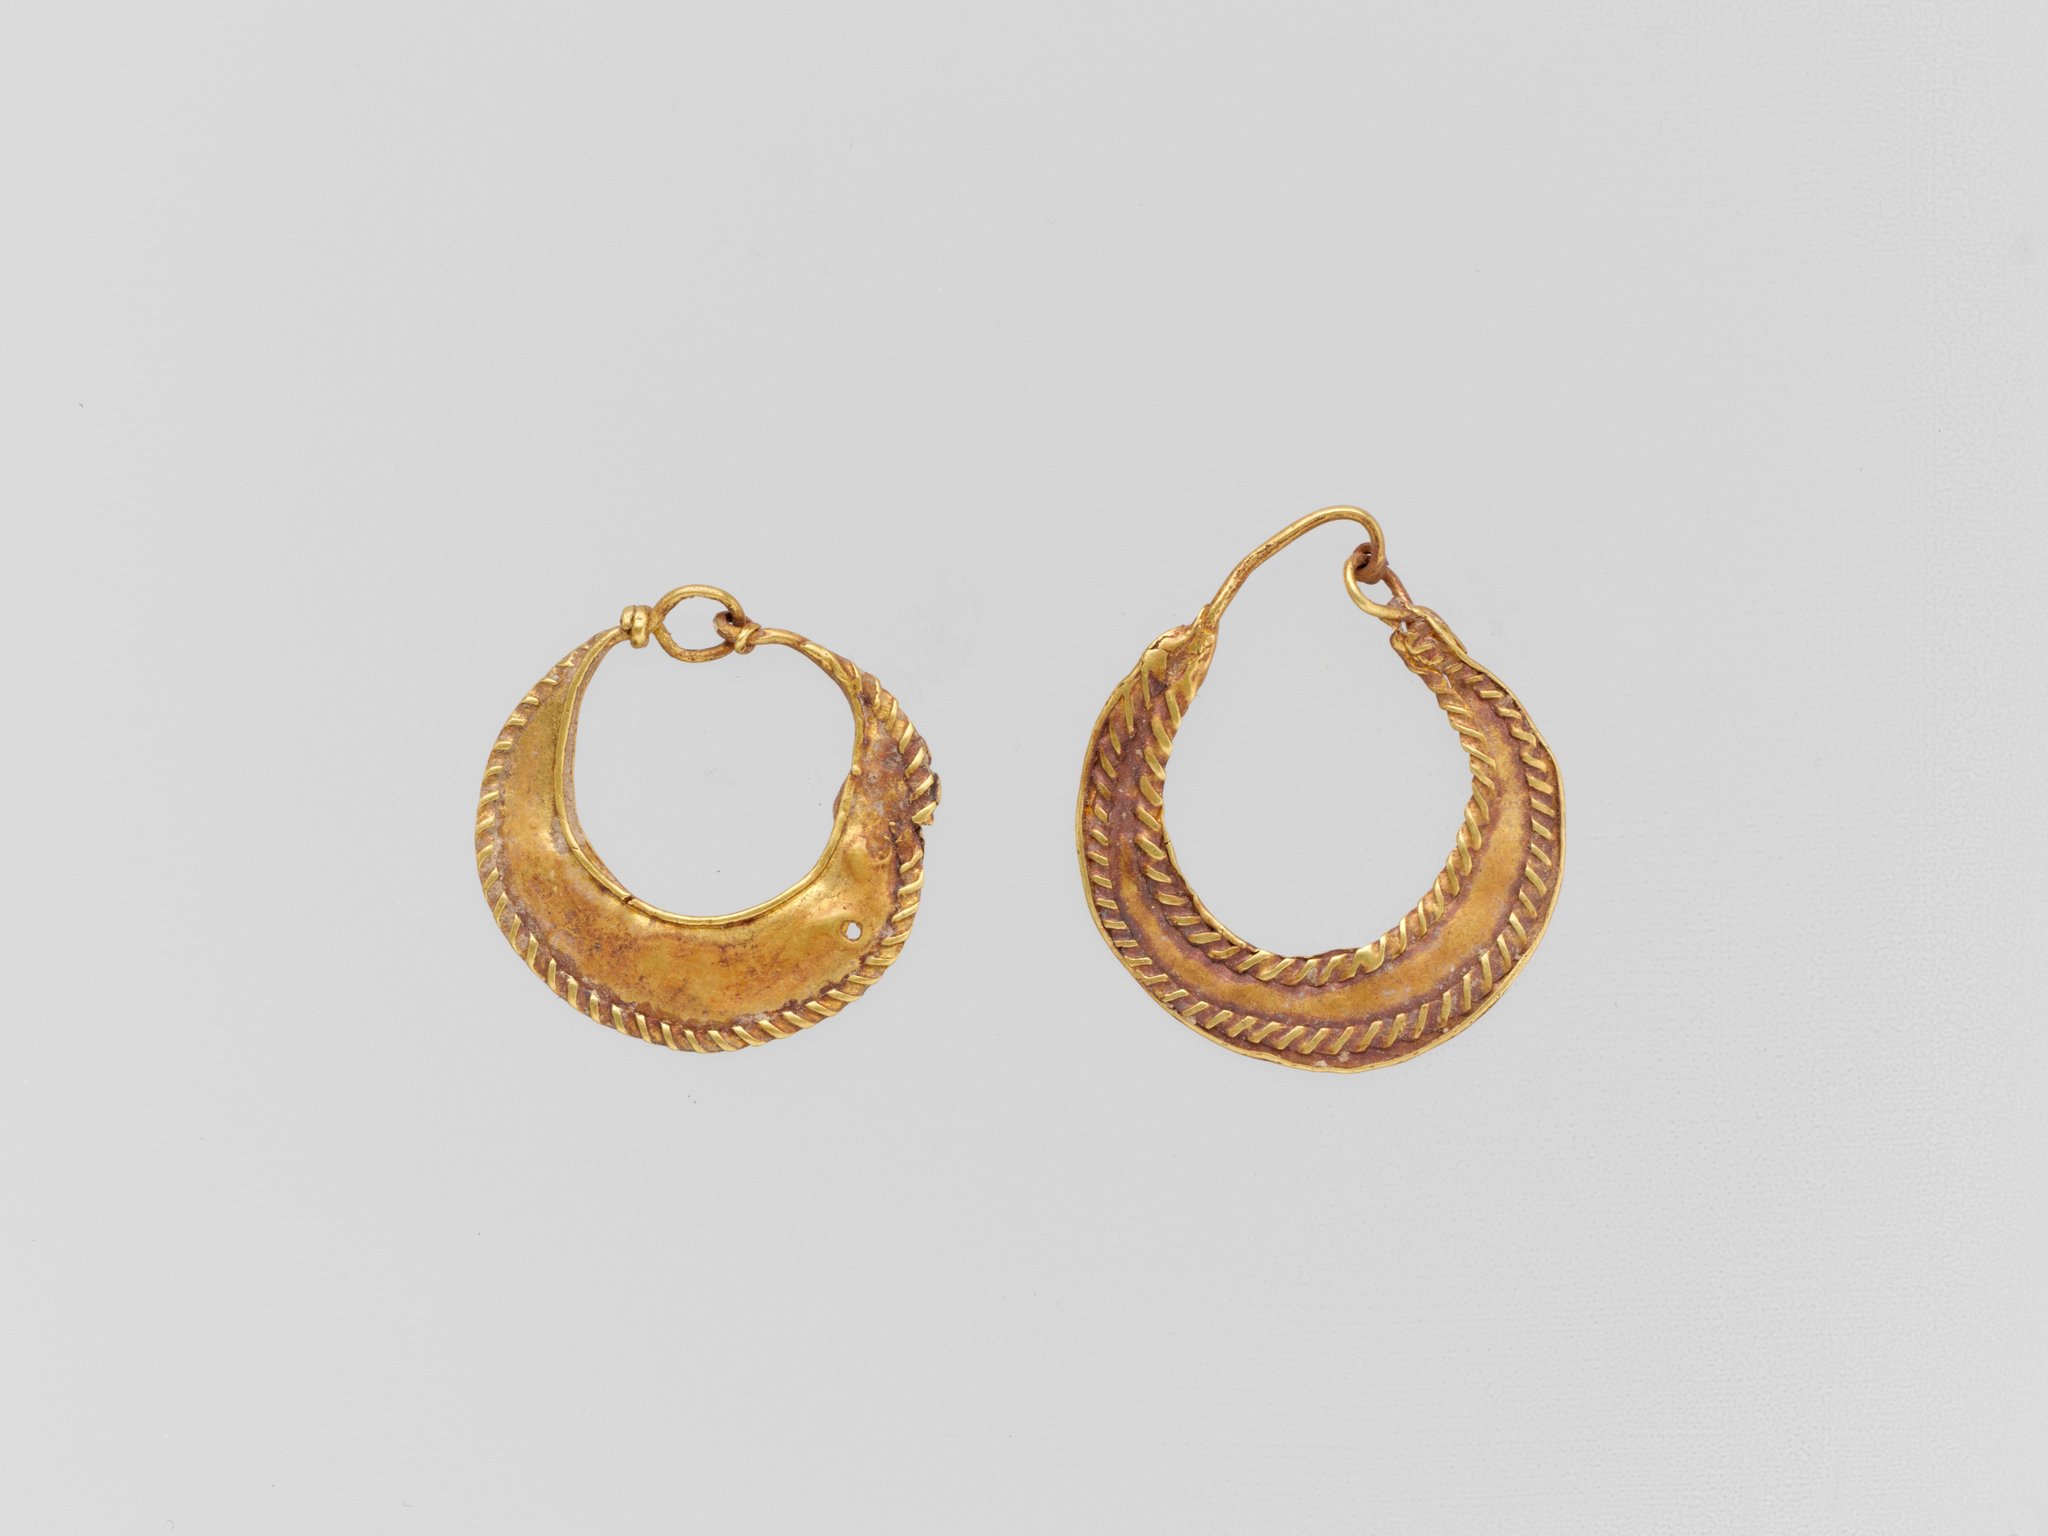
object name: earring, crescent shaped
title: Gold crescent-shaped earring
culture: cypriot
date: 500 BCE-100 CE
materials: gold